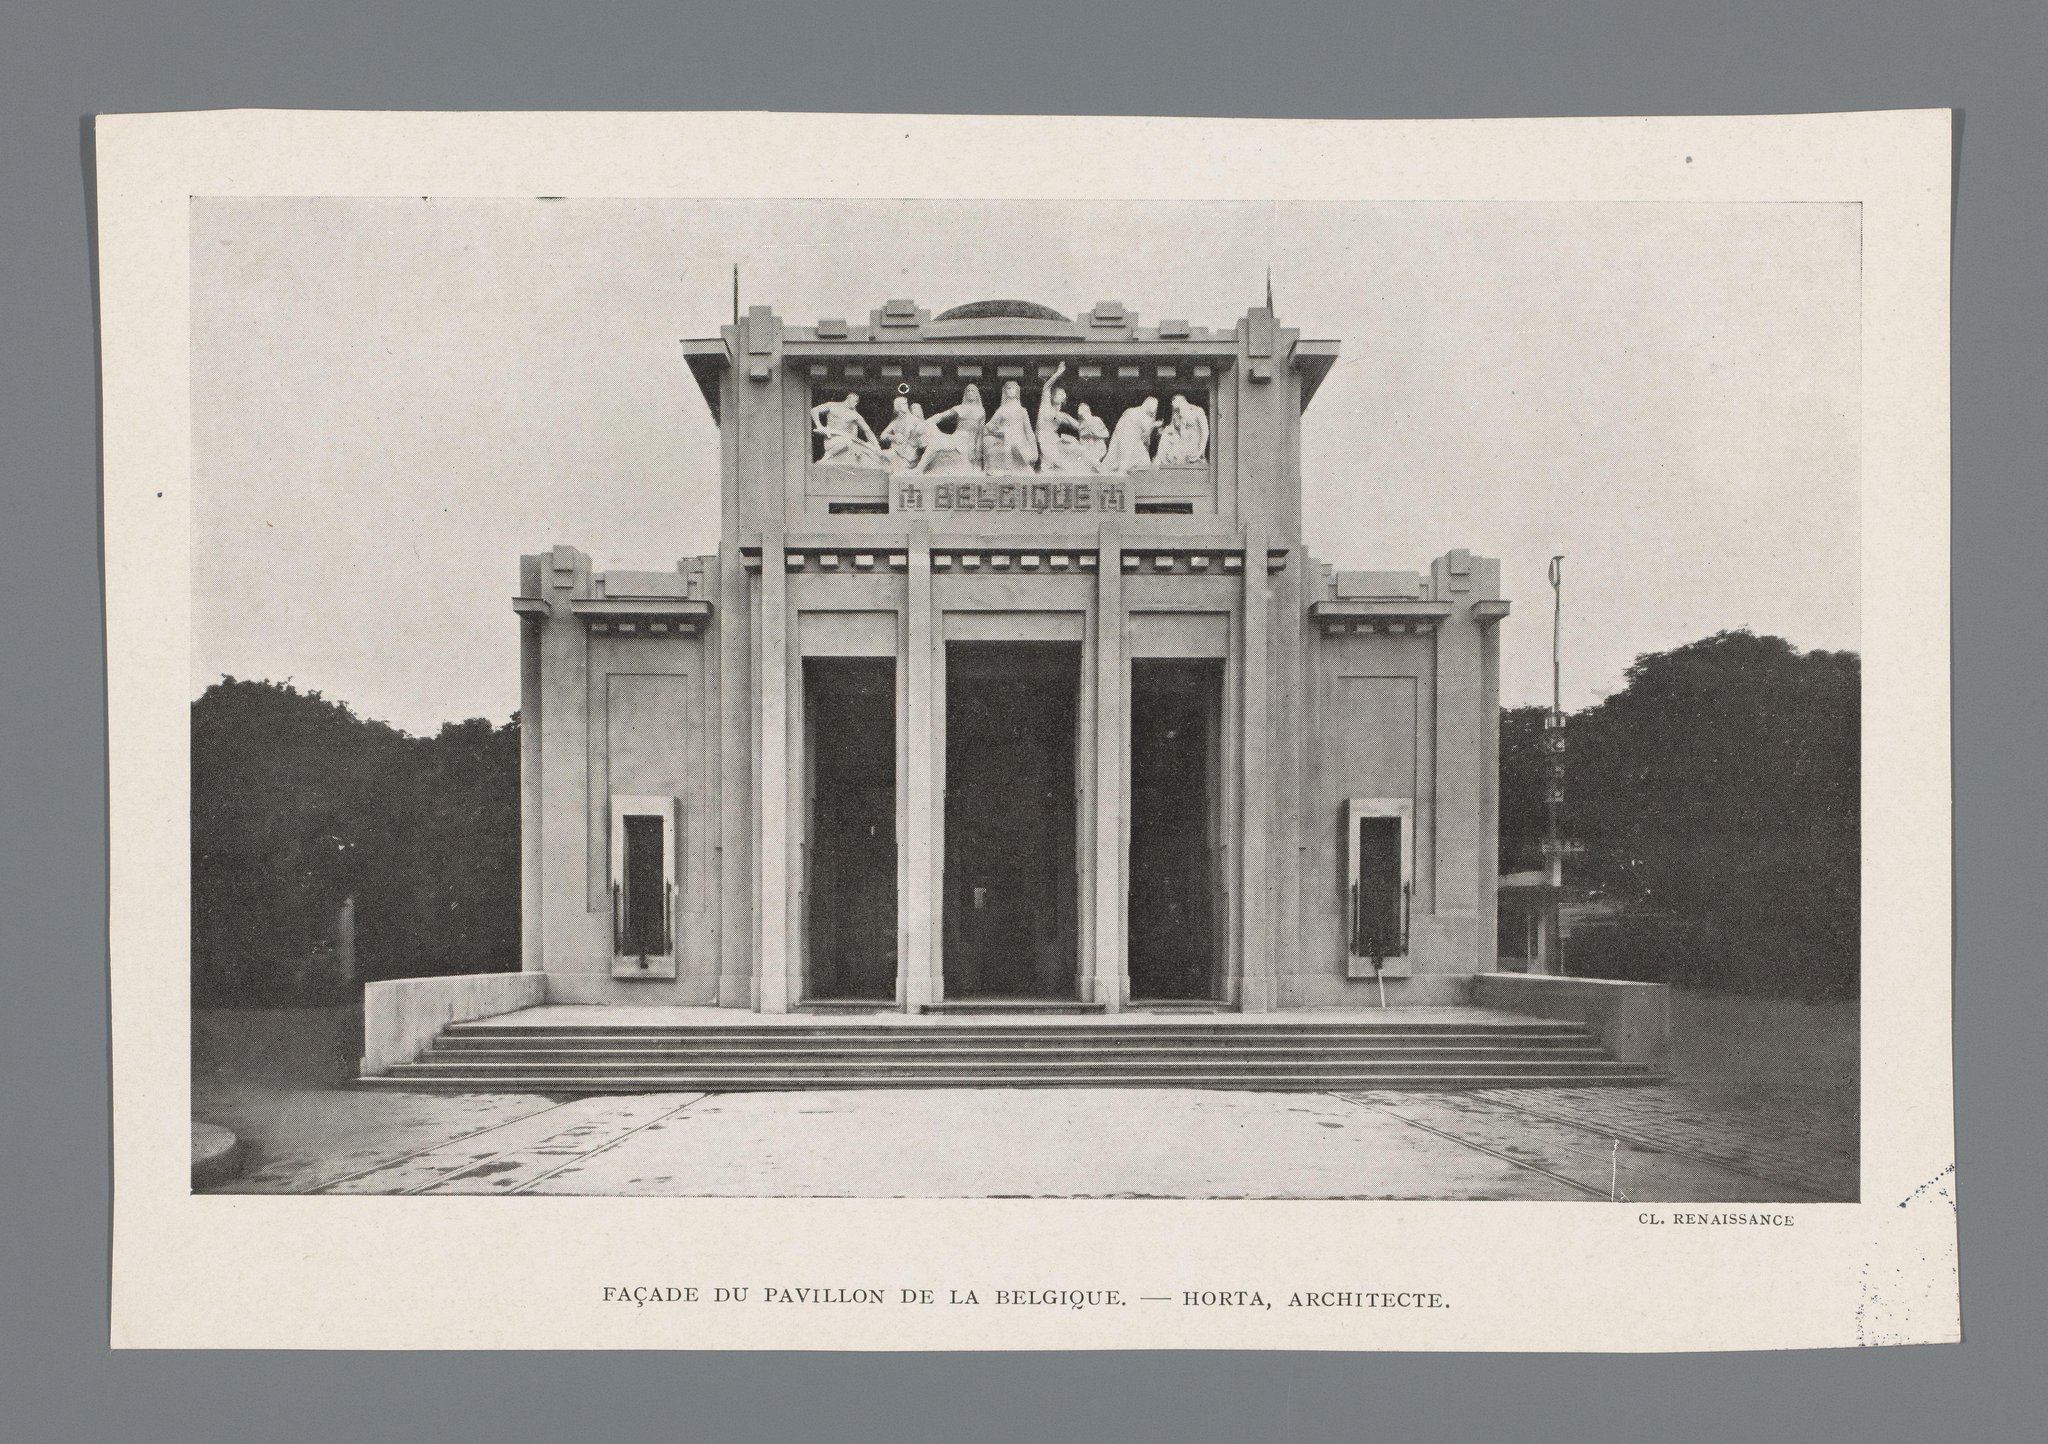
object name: photograph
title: Pavillon de la Belgique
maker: Anonymous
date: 1925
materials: photographic support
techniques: offset printed